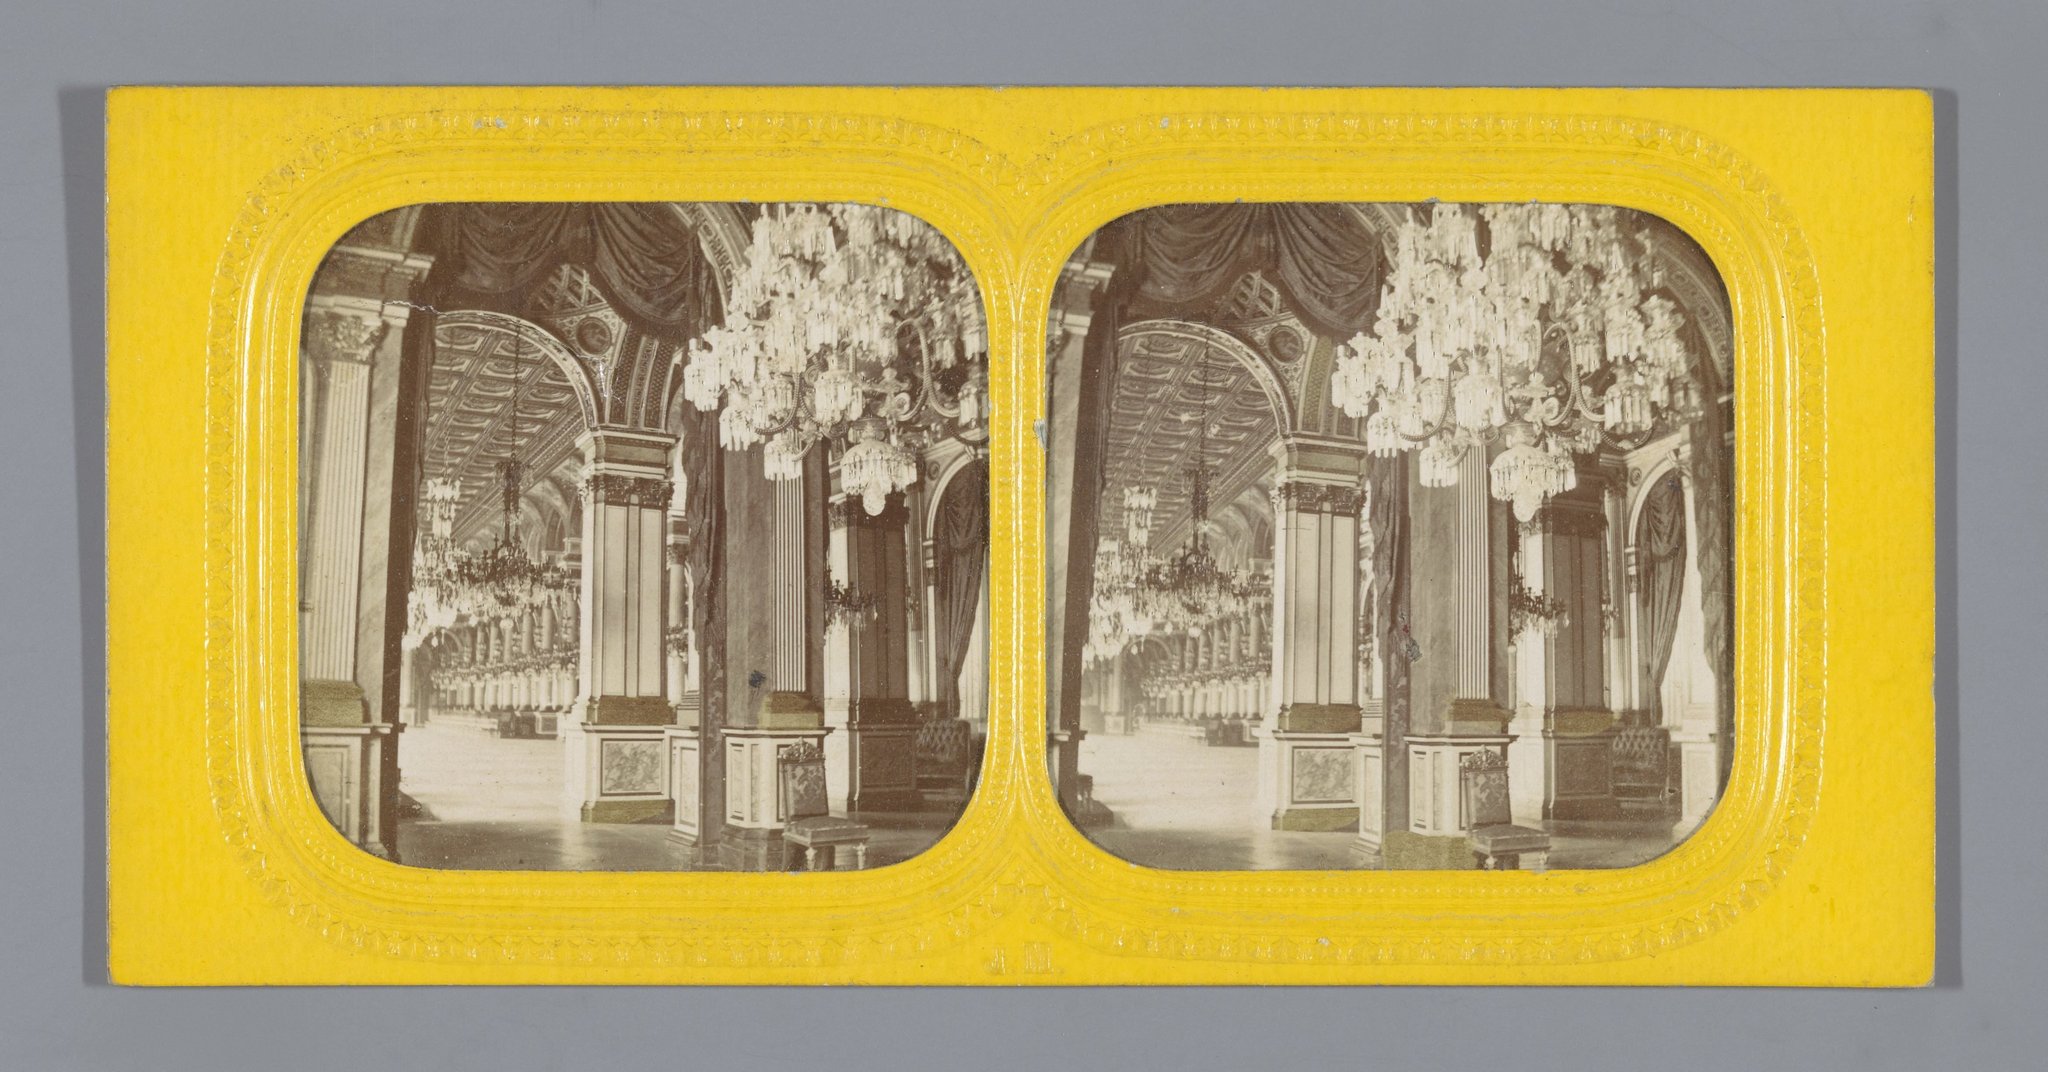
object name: tissue stereograph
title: Salon des Fêtes, Hôtel de Ville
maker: jules marinier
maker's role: publisher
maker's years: 1823-1896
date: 1864-1879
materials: cardboard, paper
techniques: albumen print, cutting, hand coloring, perforating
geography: paris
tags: palace - aa - civic architecture: inside